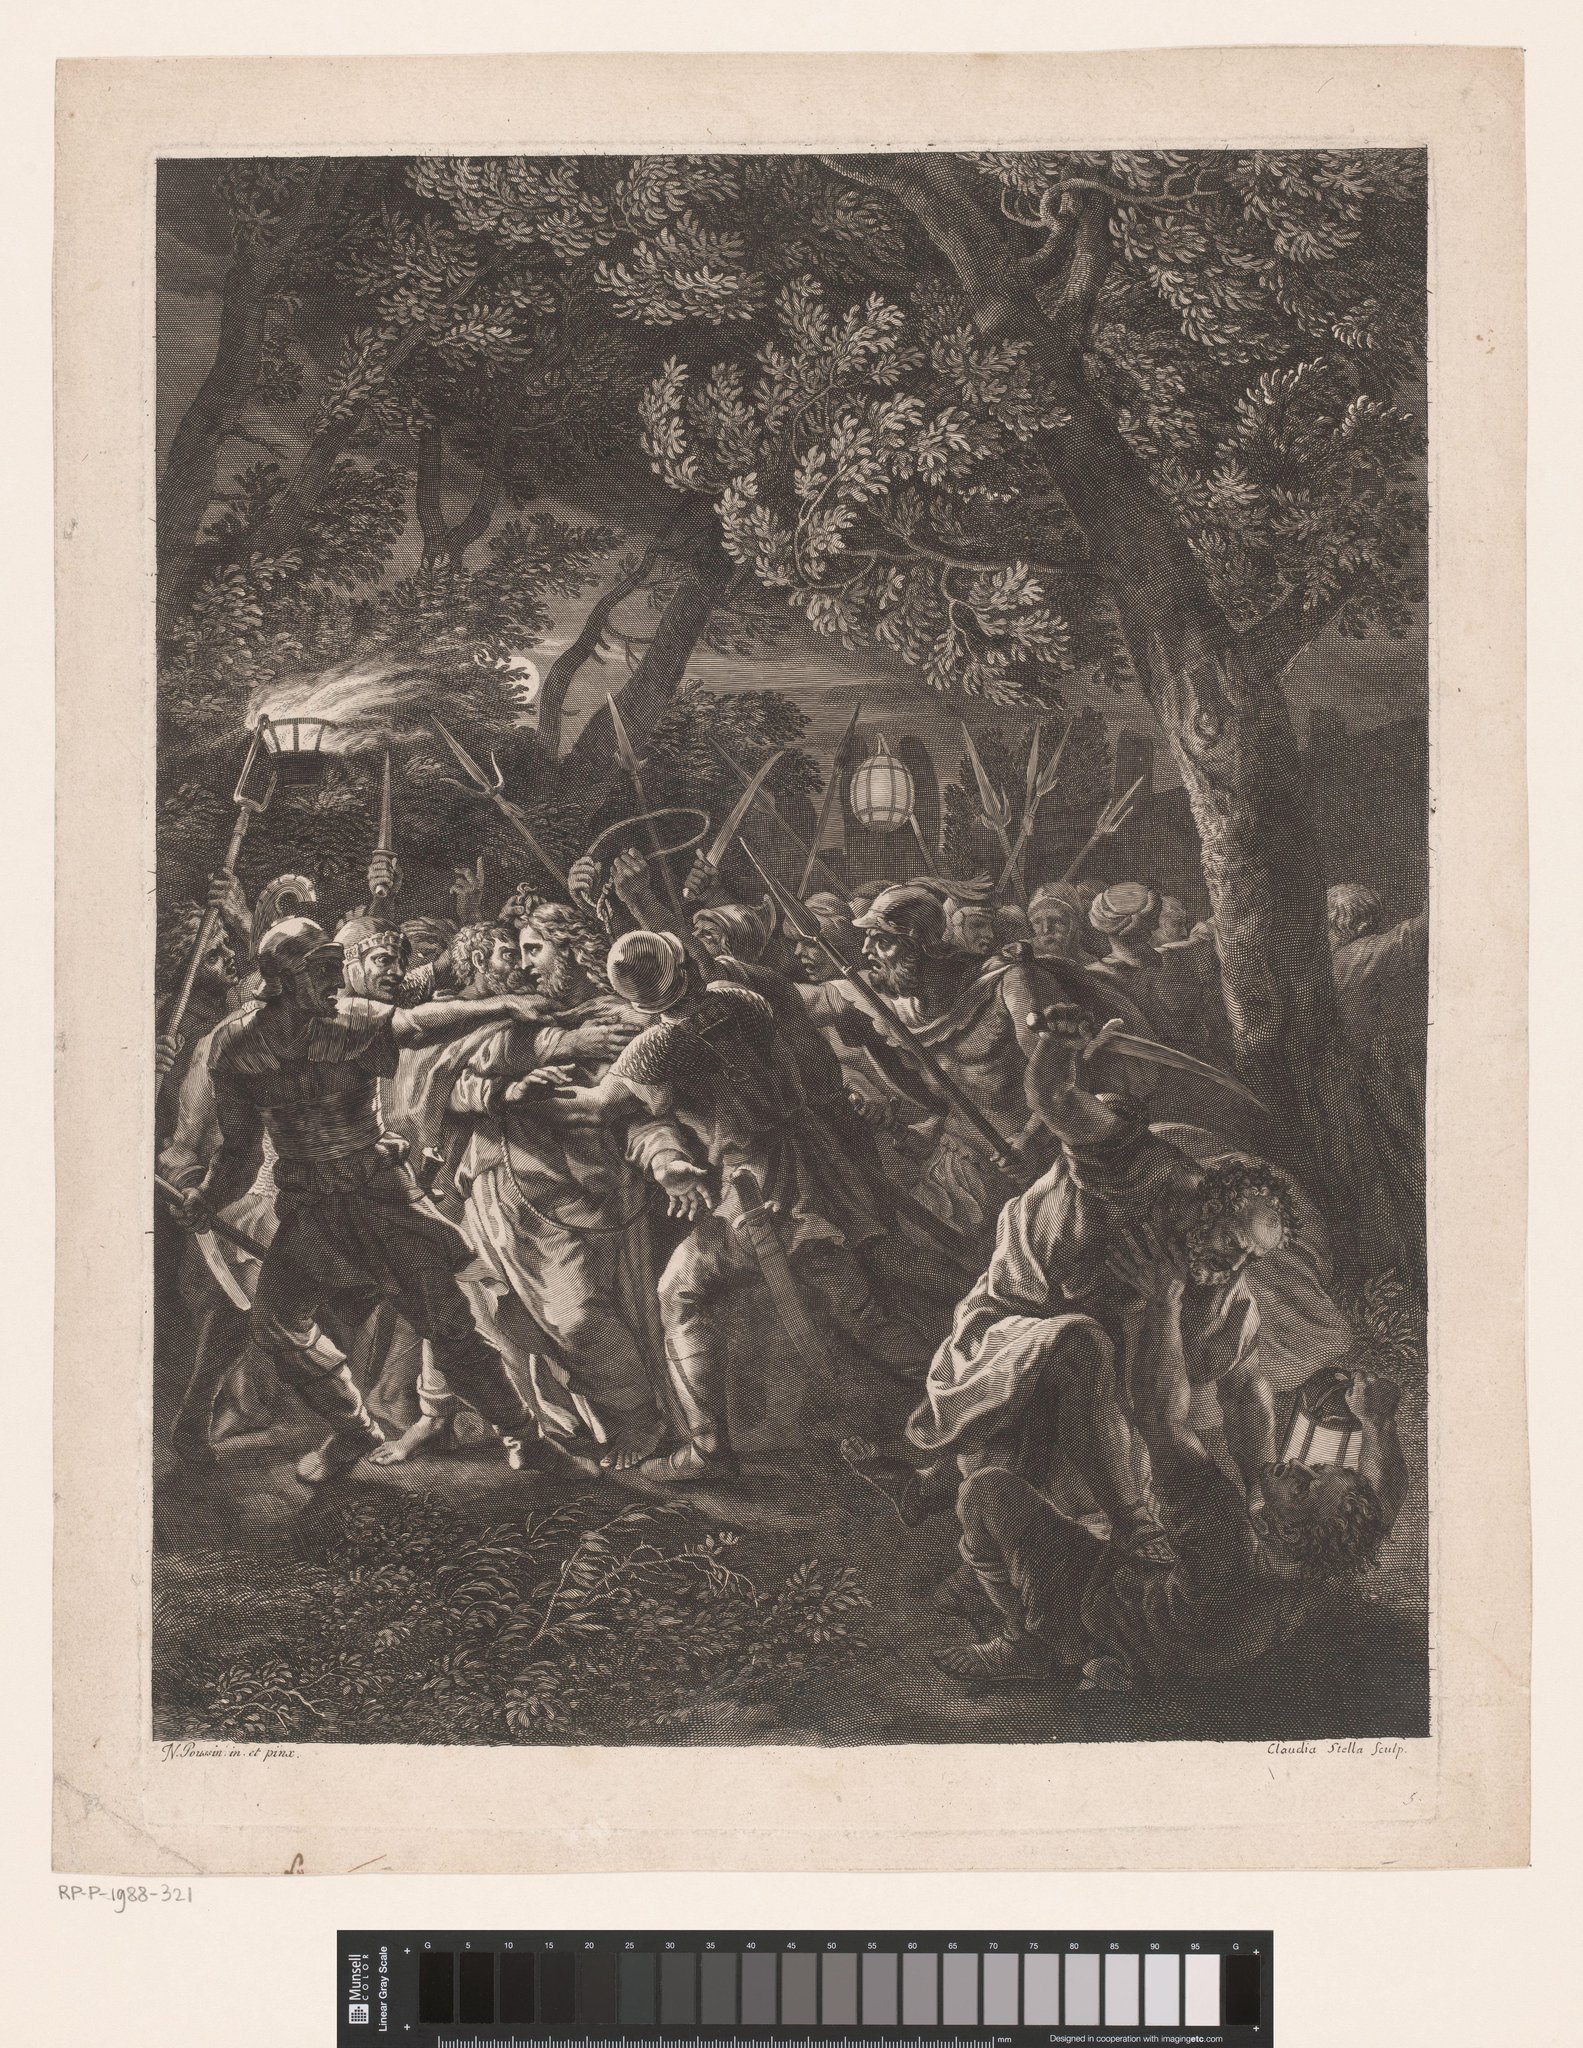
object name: print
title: De gevangenneming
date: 1646-1697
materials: paper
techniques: engraving, etching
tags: christ is led away ~ garden of gethsemane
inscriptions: collector's mark: Lugt 2228, collector's mark: Lugt 2760